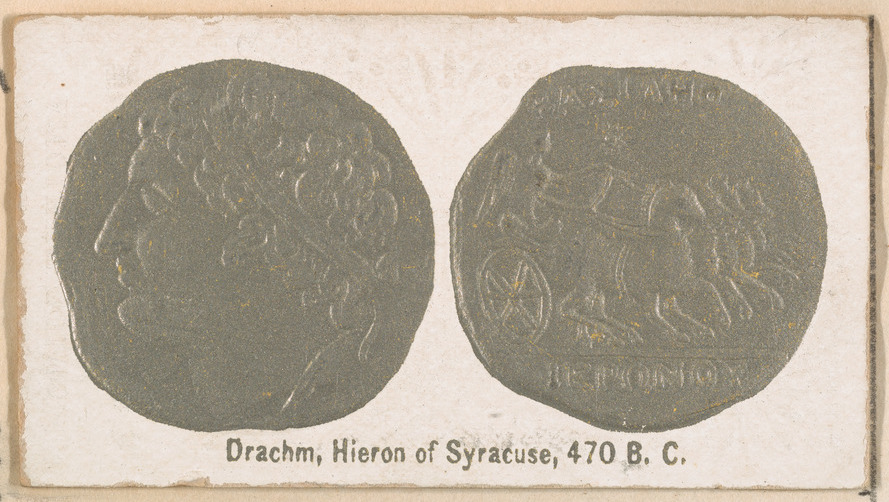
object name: print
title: Drachm, Hieron of Syracuse, 470 B.C., from the Ancient Coins series (N180) issued by Wm. S. Kimball & Co.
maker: william s. kimball & company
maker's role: publisher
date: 1888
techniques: color lithograph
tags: profiles,coins,chariots